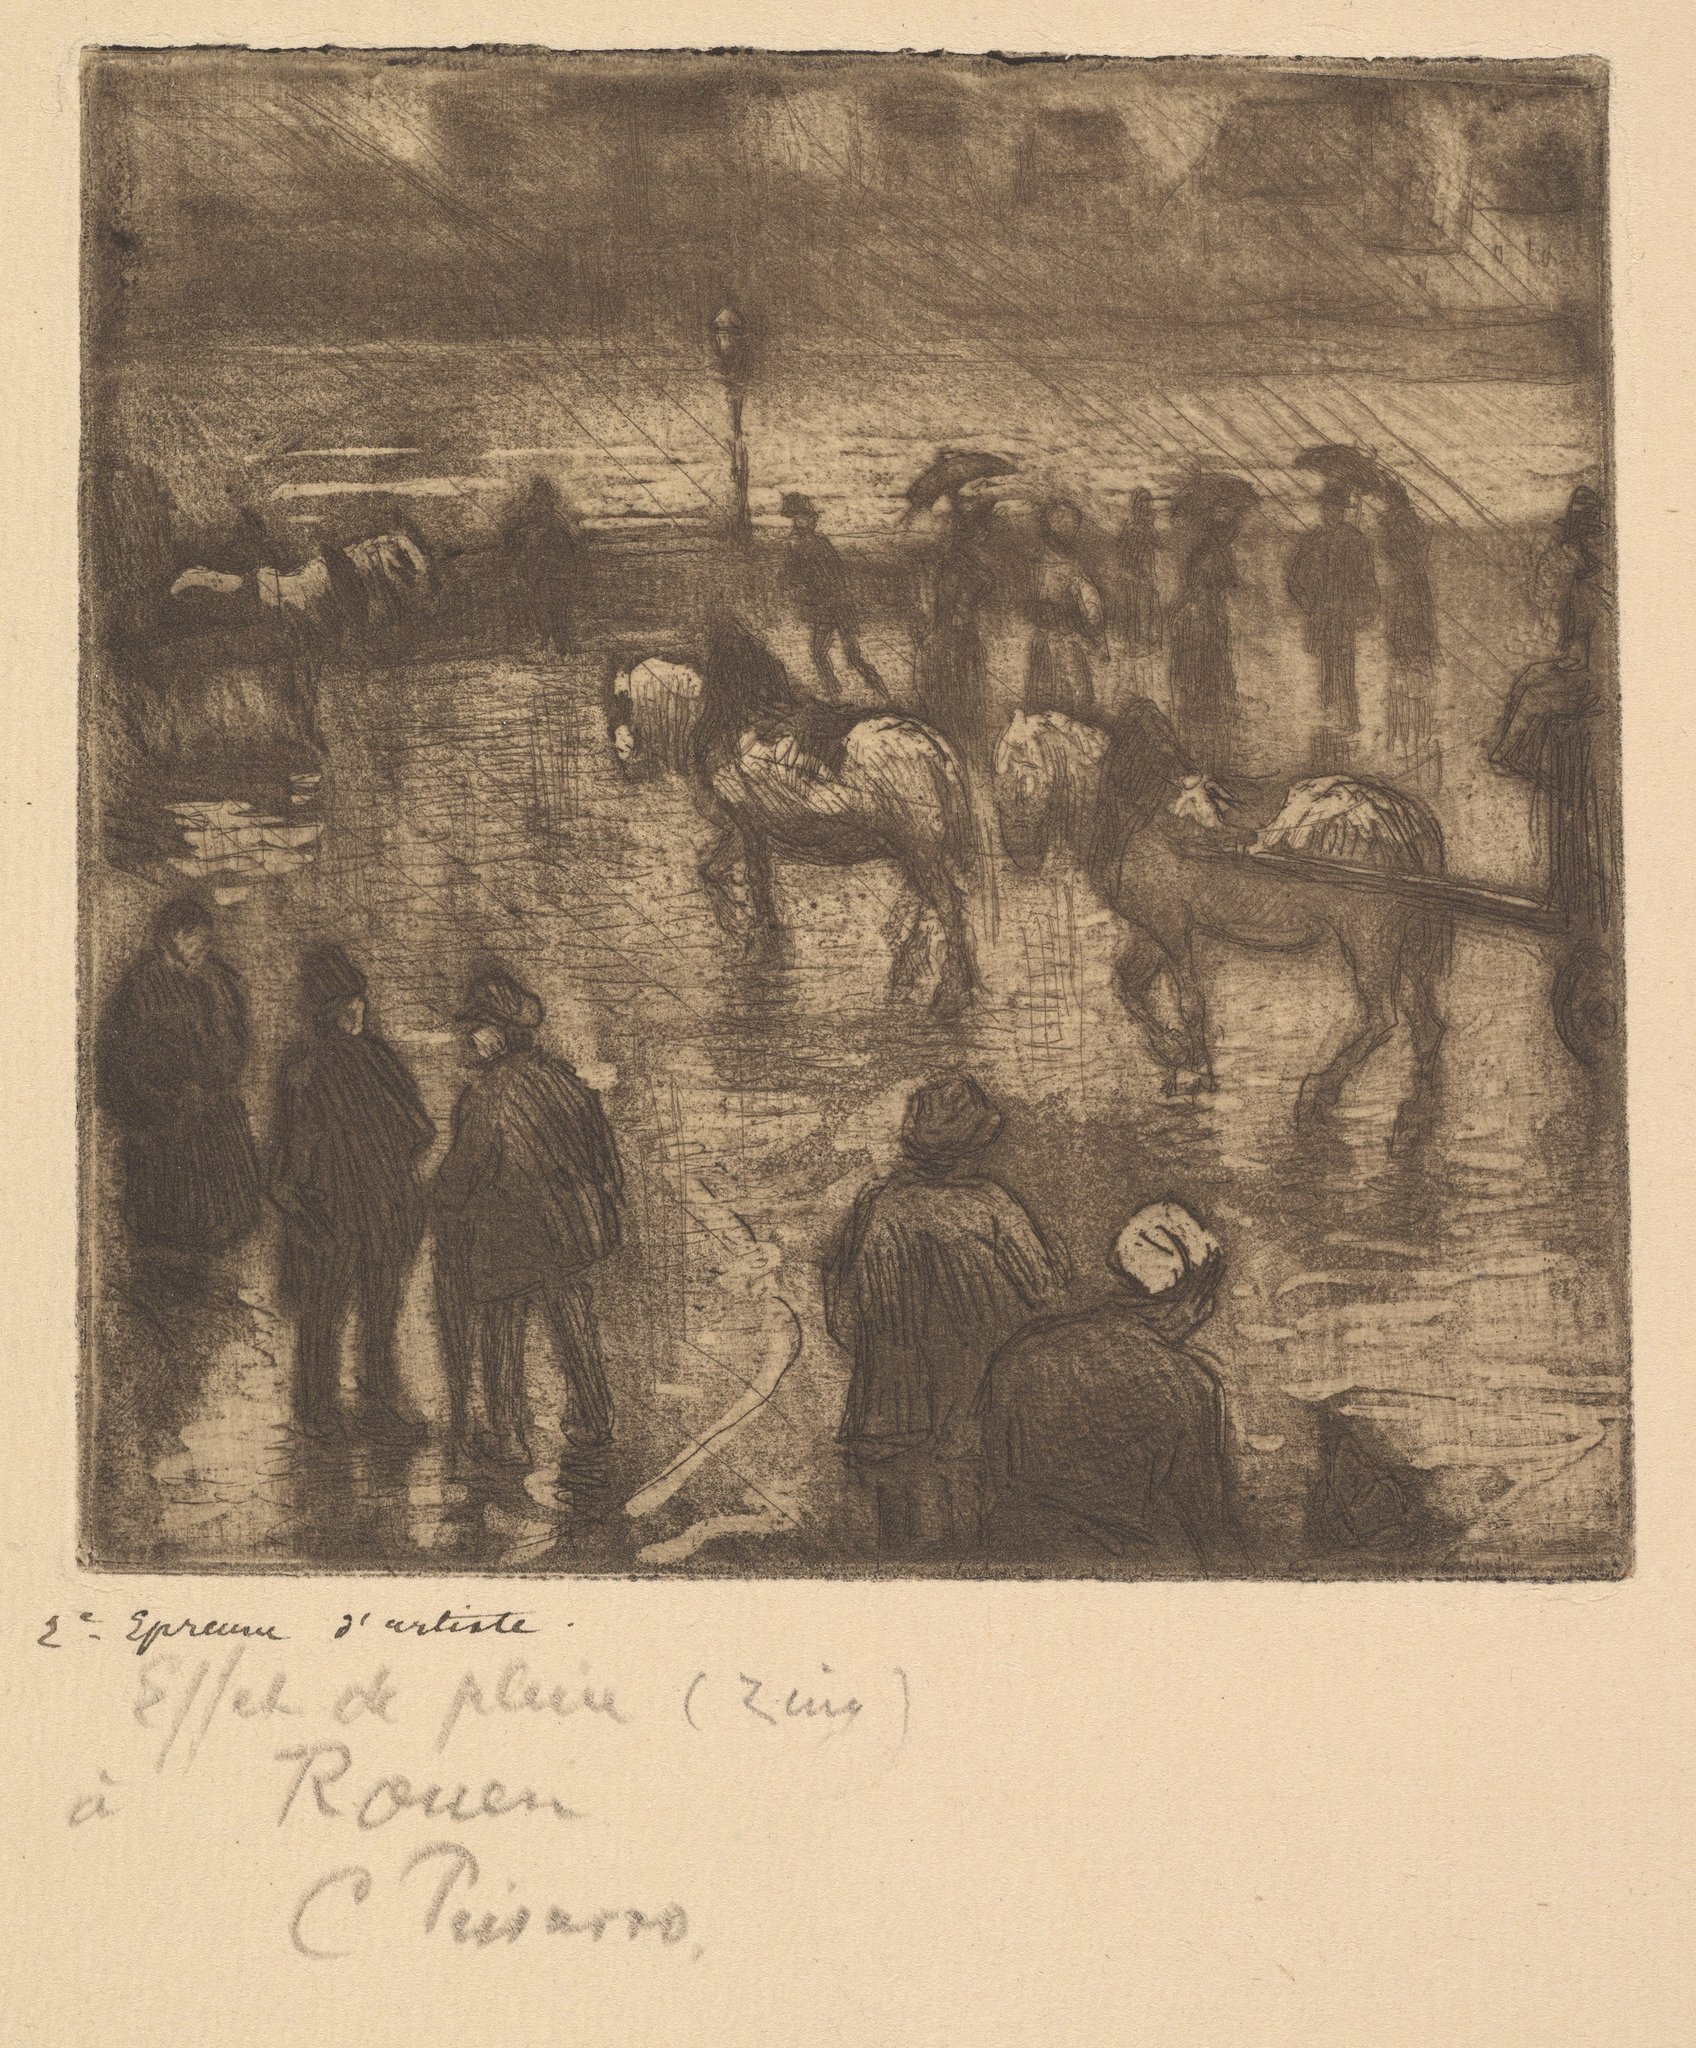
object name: print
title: Impressions of Rain, Rouen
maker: camille pissarro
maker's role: artist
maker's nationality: french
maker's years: 1830-1903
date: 1883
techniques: aquatint, drypoint, etching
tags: men,women,horses,rain